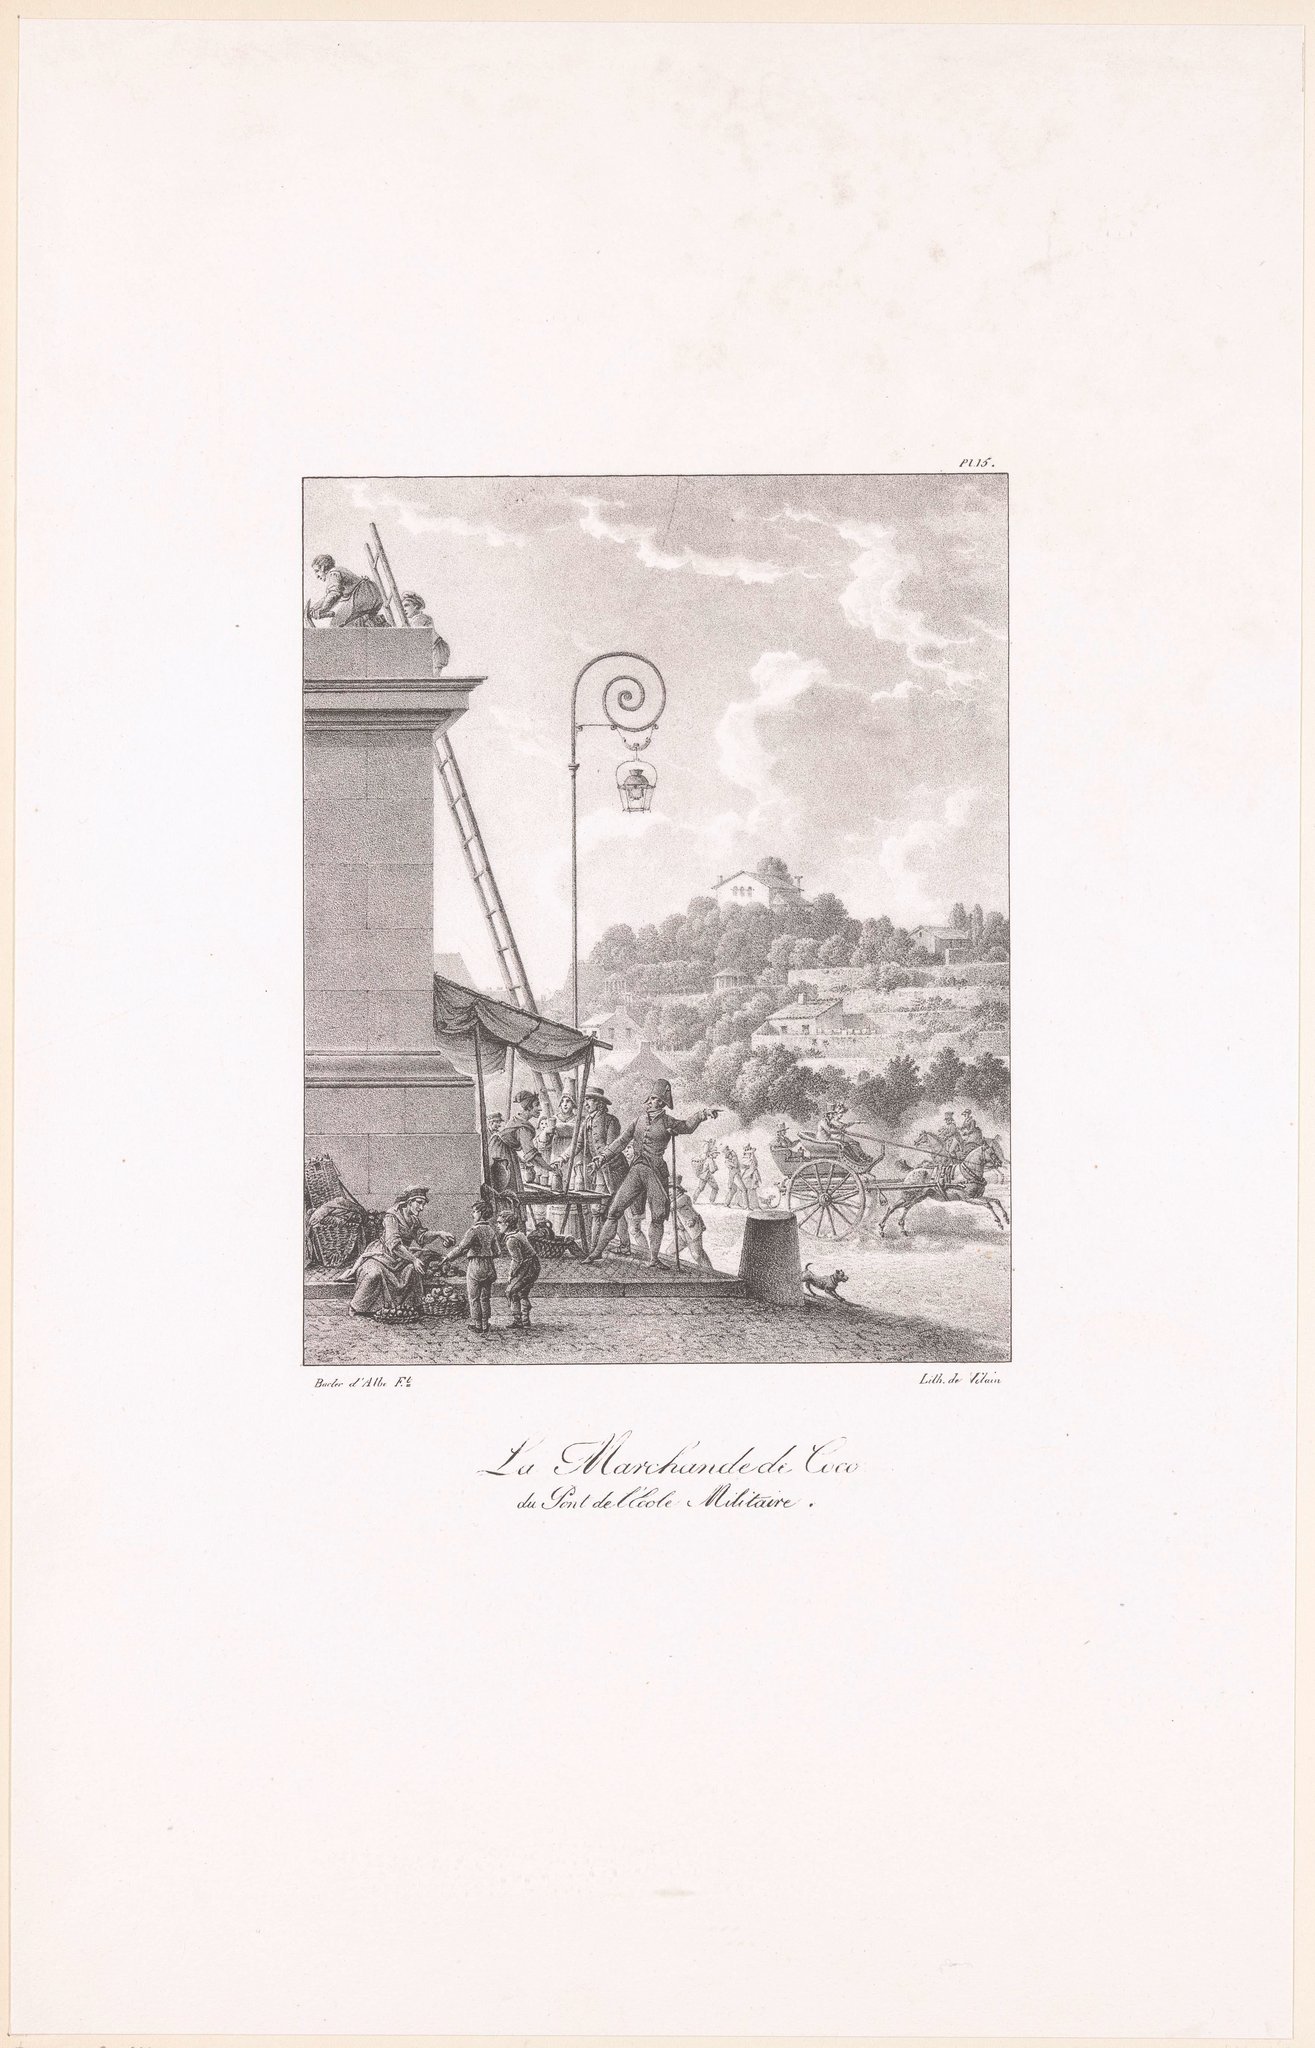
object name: print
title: Verkoopsters bij de Pont de l'École Militaire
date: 1822-1824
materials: paper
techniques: lithograph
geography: paris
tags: private soldier, merchant, salesman - bb - women engaged in trade and commerce, bridge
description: Twee straatventsters, onder wie een coco-verkoopster, bieden hun waar aan hun klanten aan, onder wie een militair.